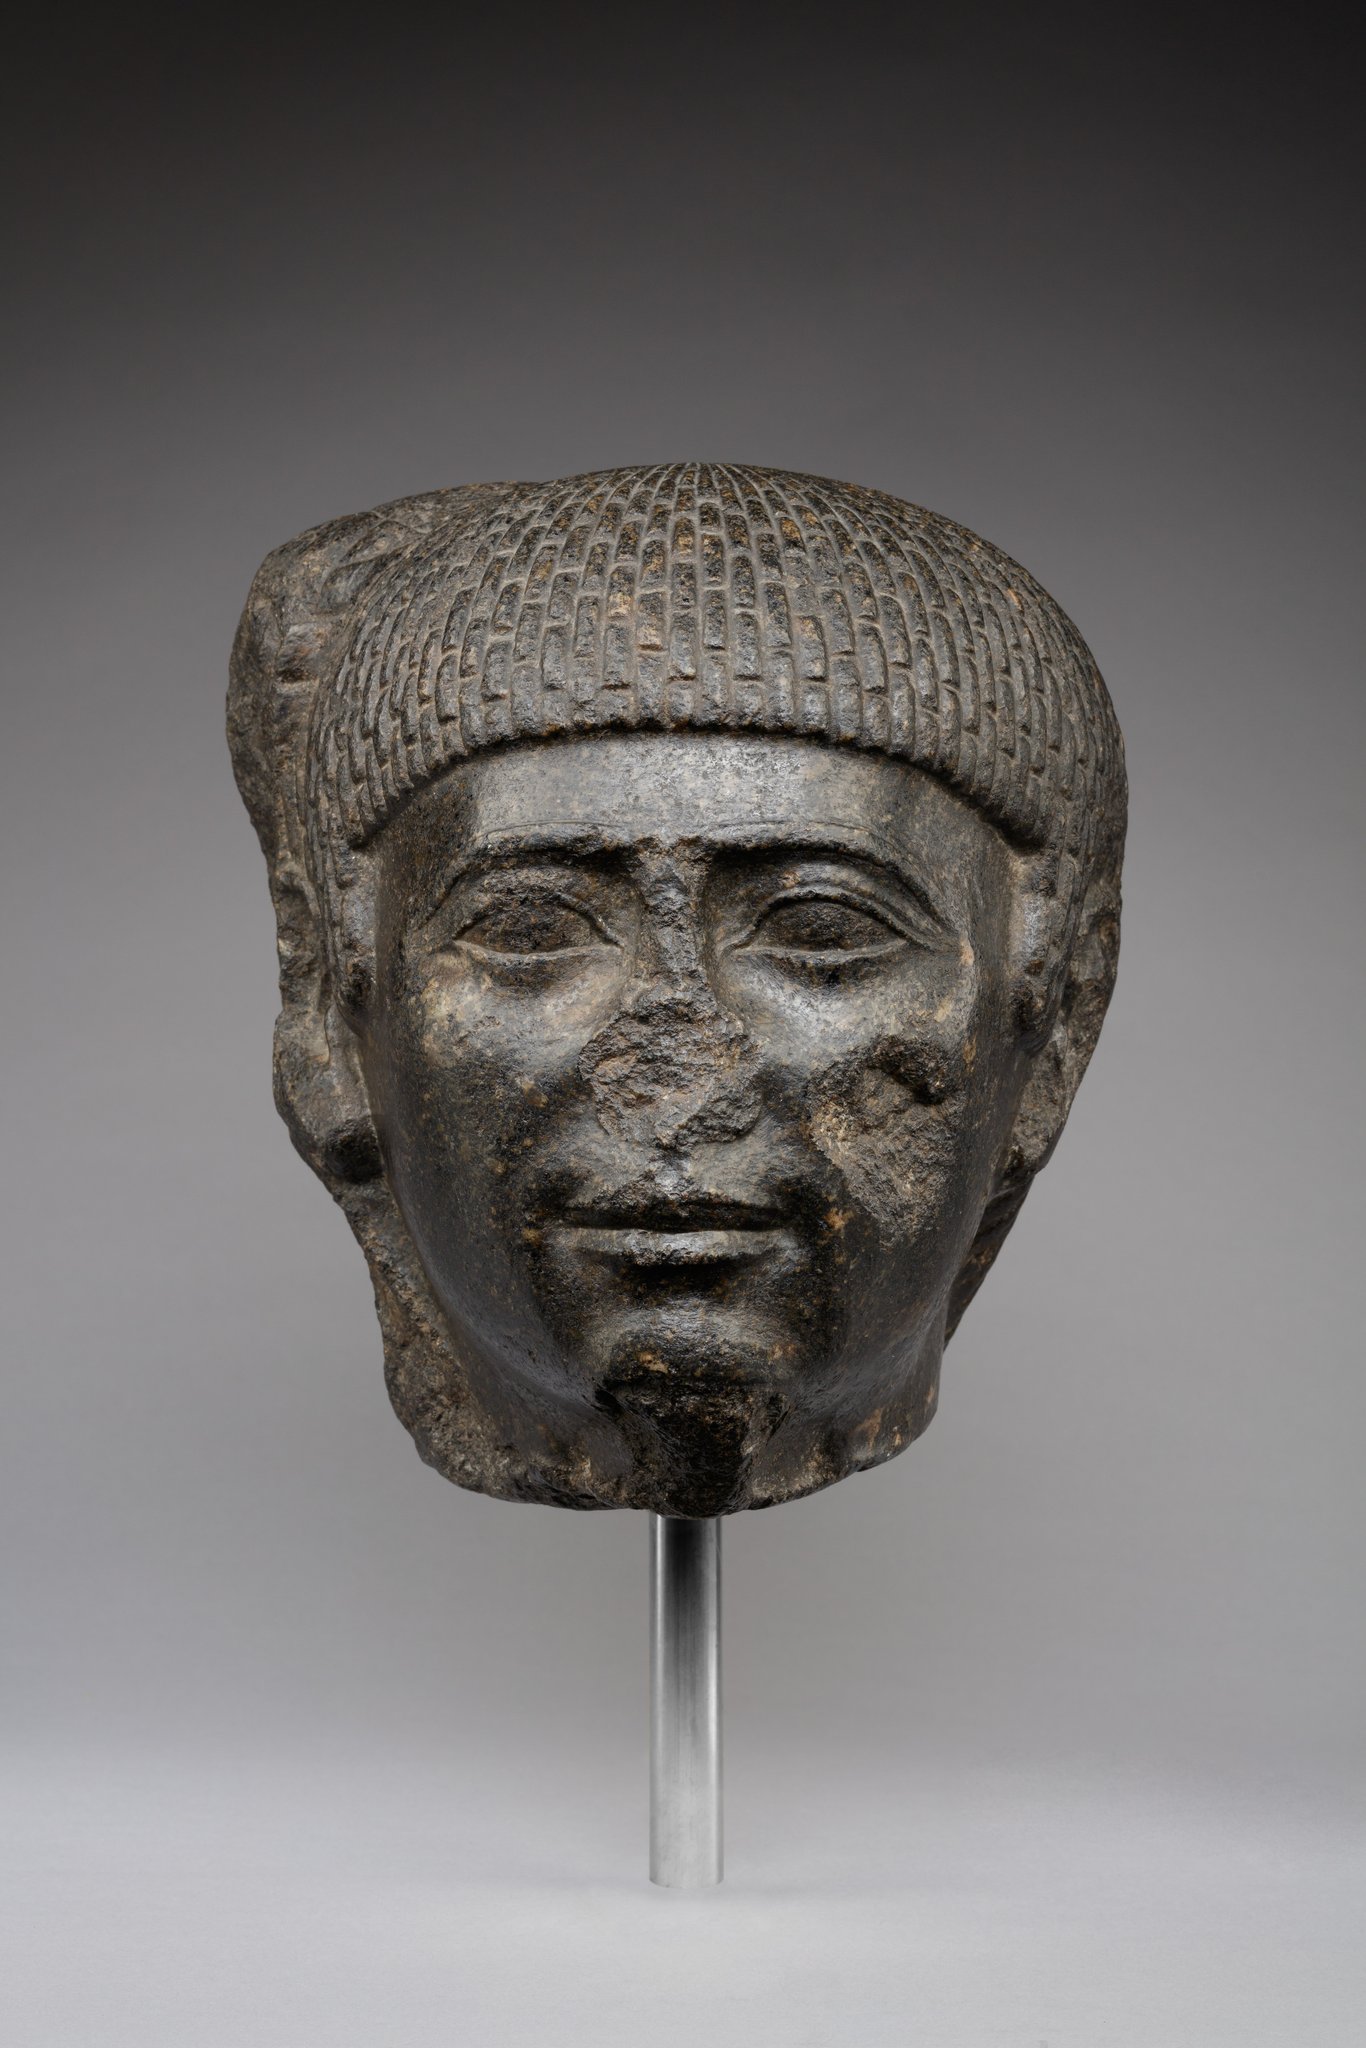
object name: head, high priest of ptah or prince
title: High Priest of Ptah or Crown Prince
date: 750-664 BCE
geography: egypt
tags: heads,men